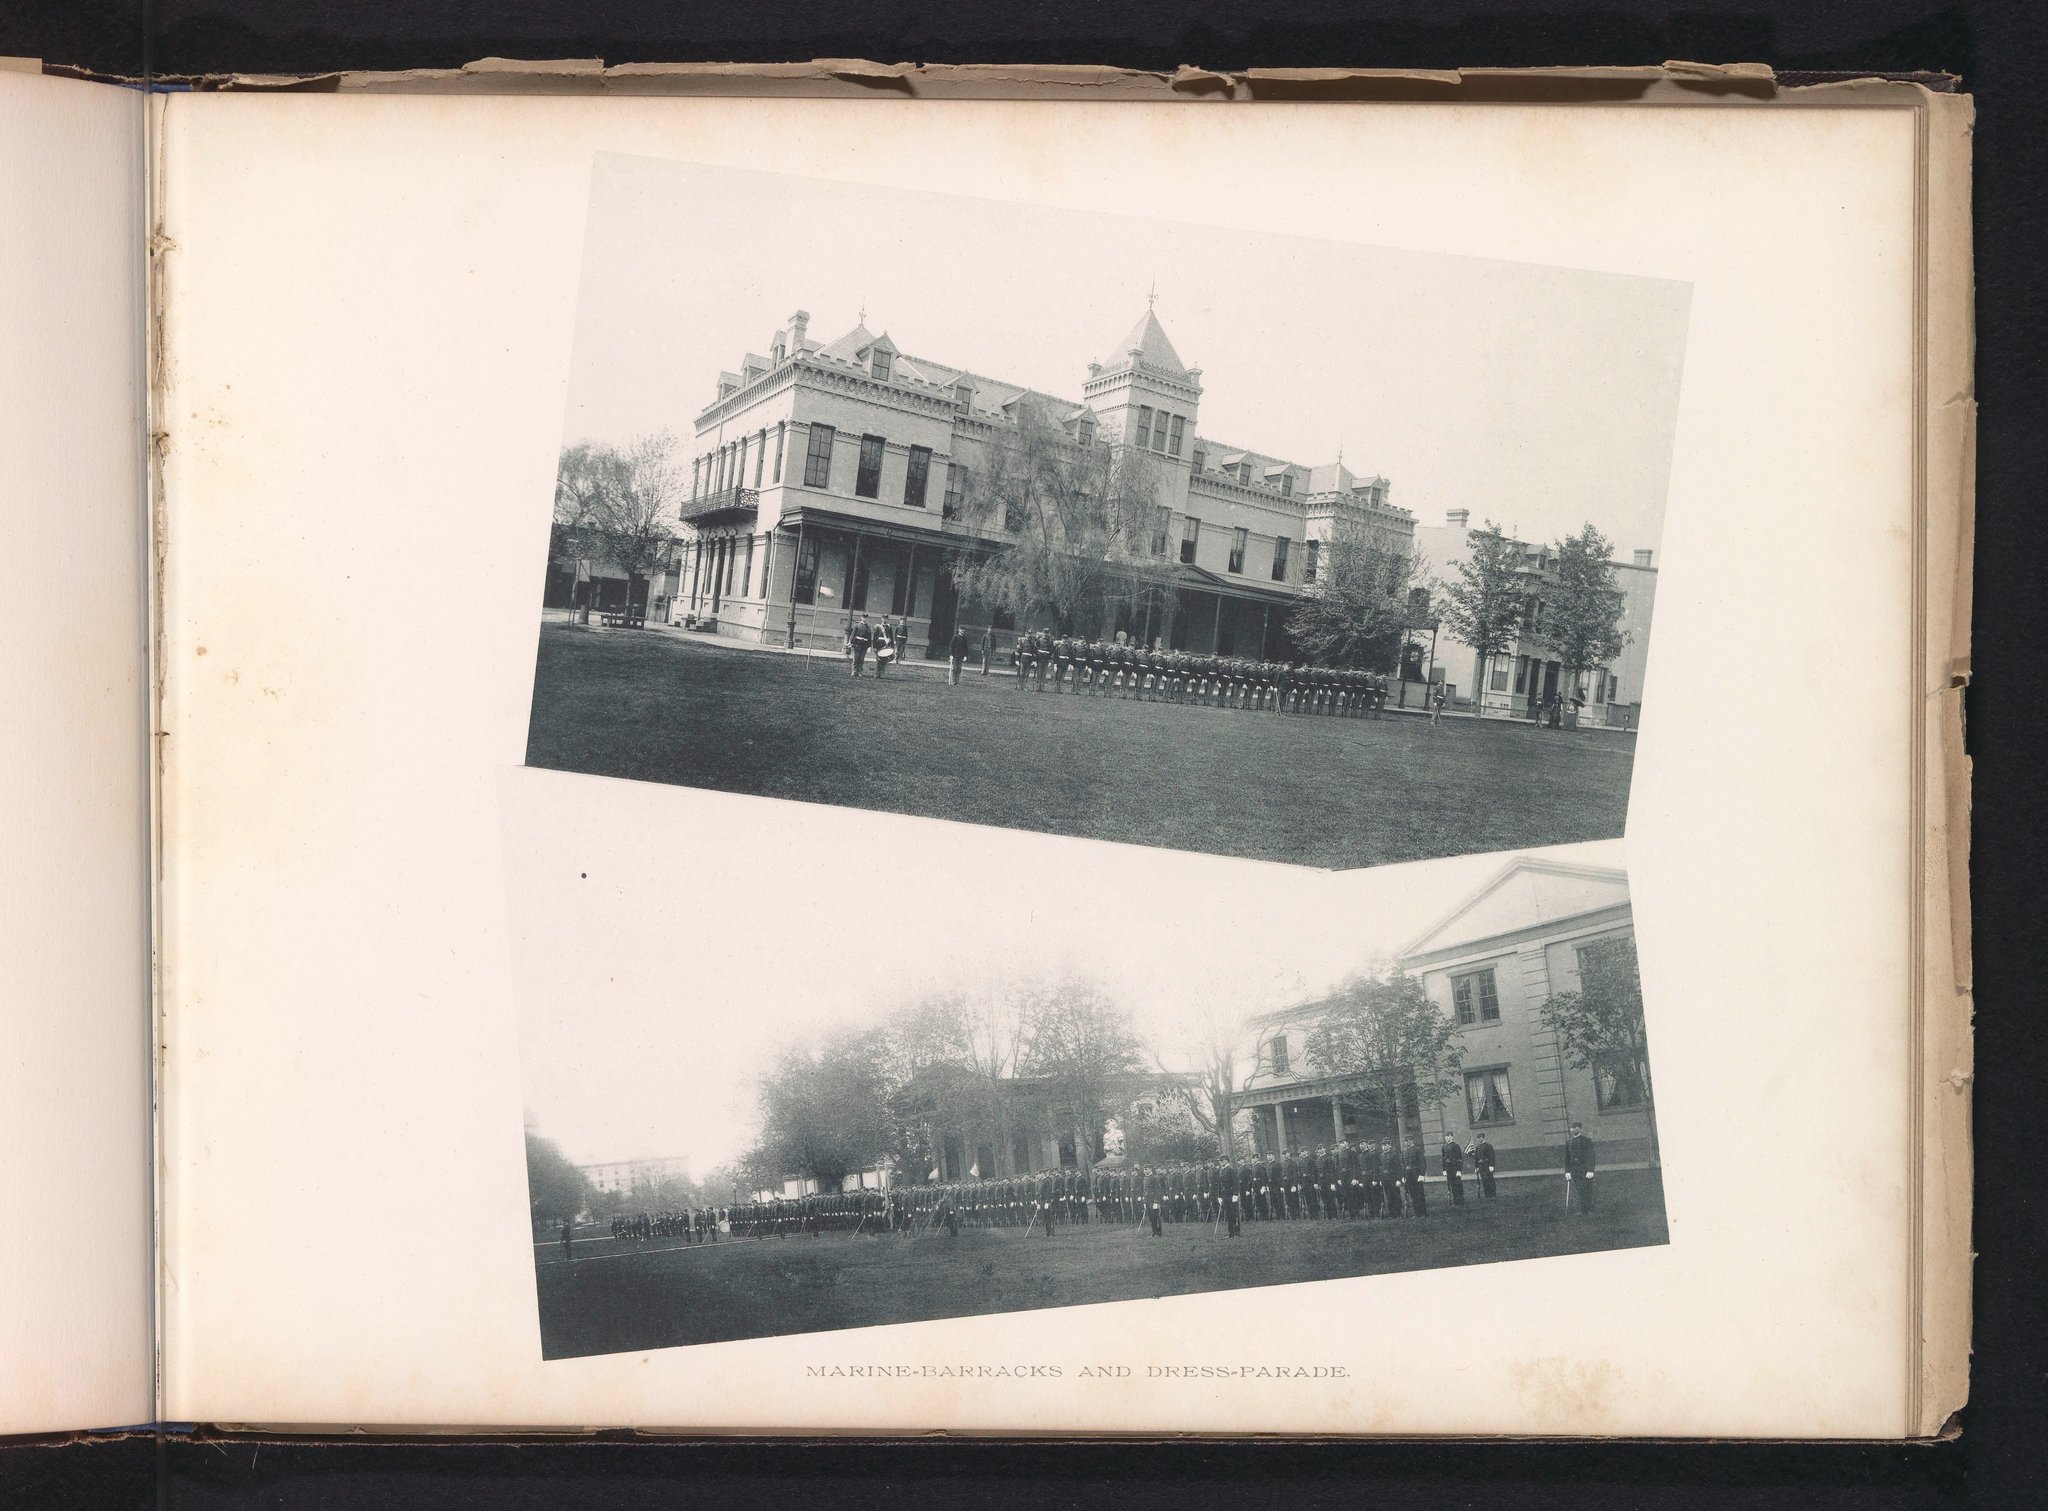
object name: page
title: Marine-barracks and dress-parade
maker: edward h. hart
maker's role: publisher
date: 1885-1890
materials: paper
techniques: photograph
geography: new york city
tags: military academy, military parade, pageant, façade (of house or building), barracks